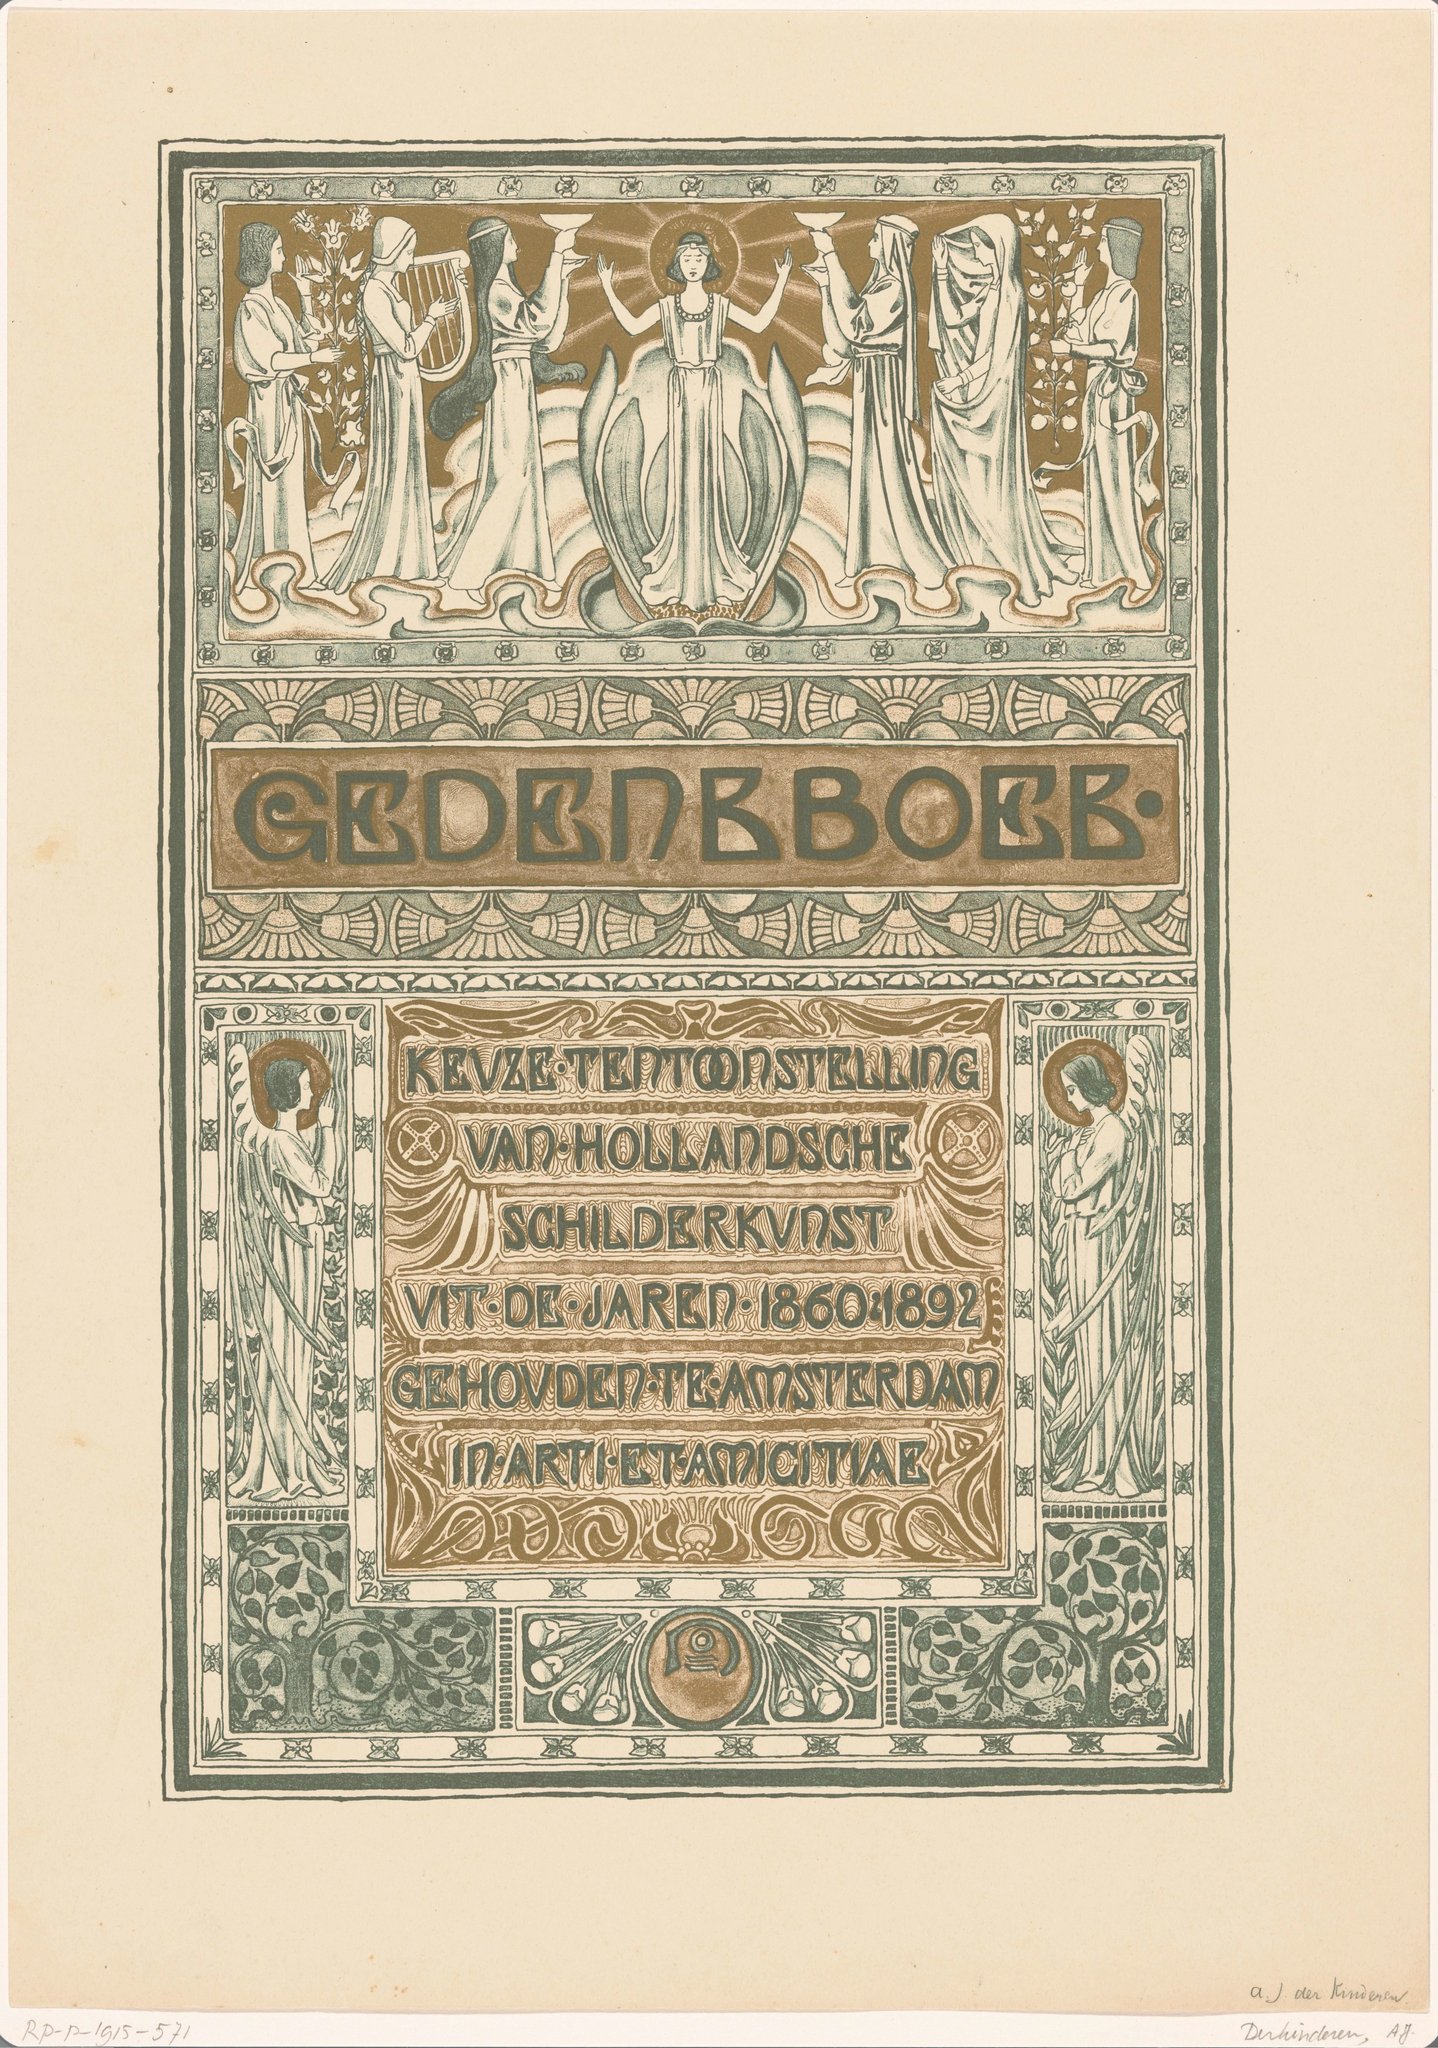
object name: titelblad, titelpagina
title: Titelpagina van Gedenkboek: Keuze-tentoonstelling van Hollandsche schilderkunst uit de jaren 1860-1892, gehouden te Amsterdam in Arti et Amicitiae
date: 1893-1894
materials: paper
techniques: lithograph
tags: beauty; 'bellezza' (ripa), flowers: lotus, angels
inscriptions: collector's mark: Lugt 2233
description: Een vrouw, de personificatie van de schoonheid, rijst op uit een lotusbloem. Een vrouw met een harp, de personificatie van de harmonie, en een vrouw met een opgeheven sluier, de personificatie van de waarneming, brengen haar een offer. Onder de voorstelling vakken die tekst en decoratie bevatten. Naast de ondertitel twee engelen. De engel met klimop en gevouwen handen symboliseert trouw, de engel met lelie en handen op het hart symboliseert zuiverheid.